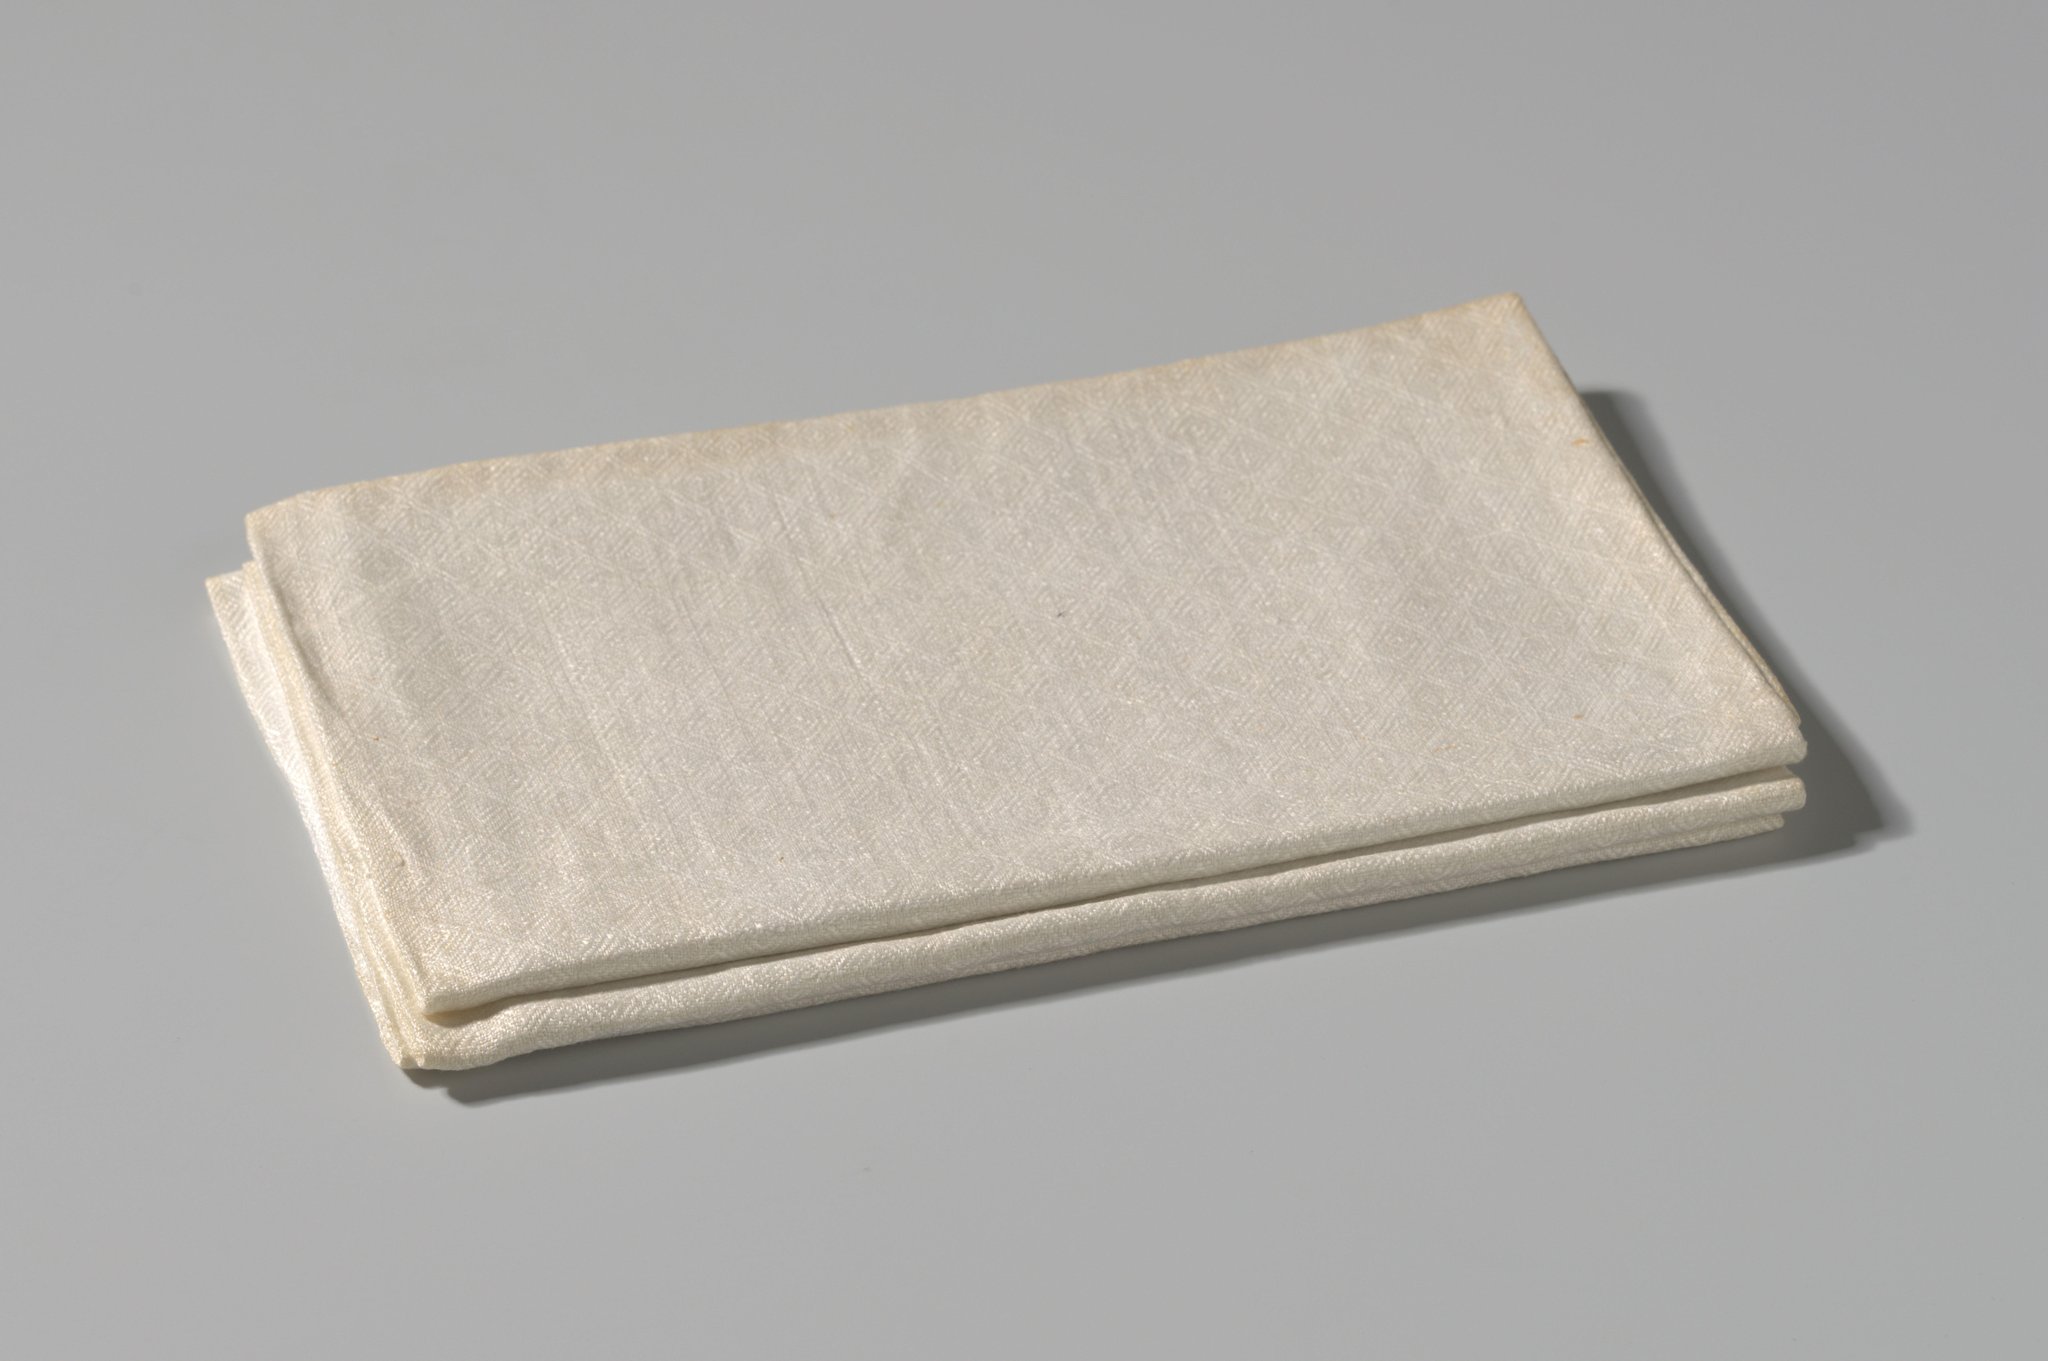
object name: towel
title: Handdoek van wit linnen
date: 1850-1875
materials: linen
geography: northern netherlands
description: Wit linnen handdoek met een kraanoog patroon, merk HW.